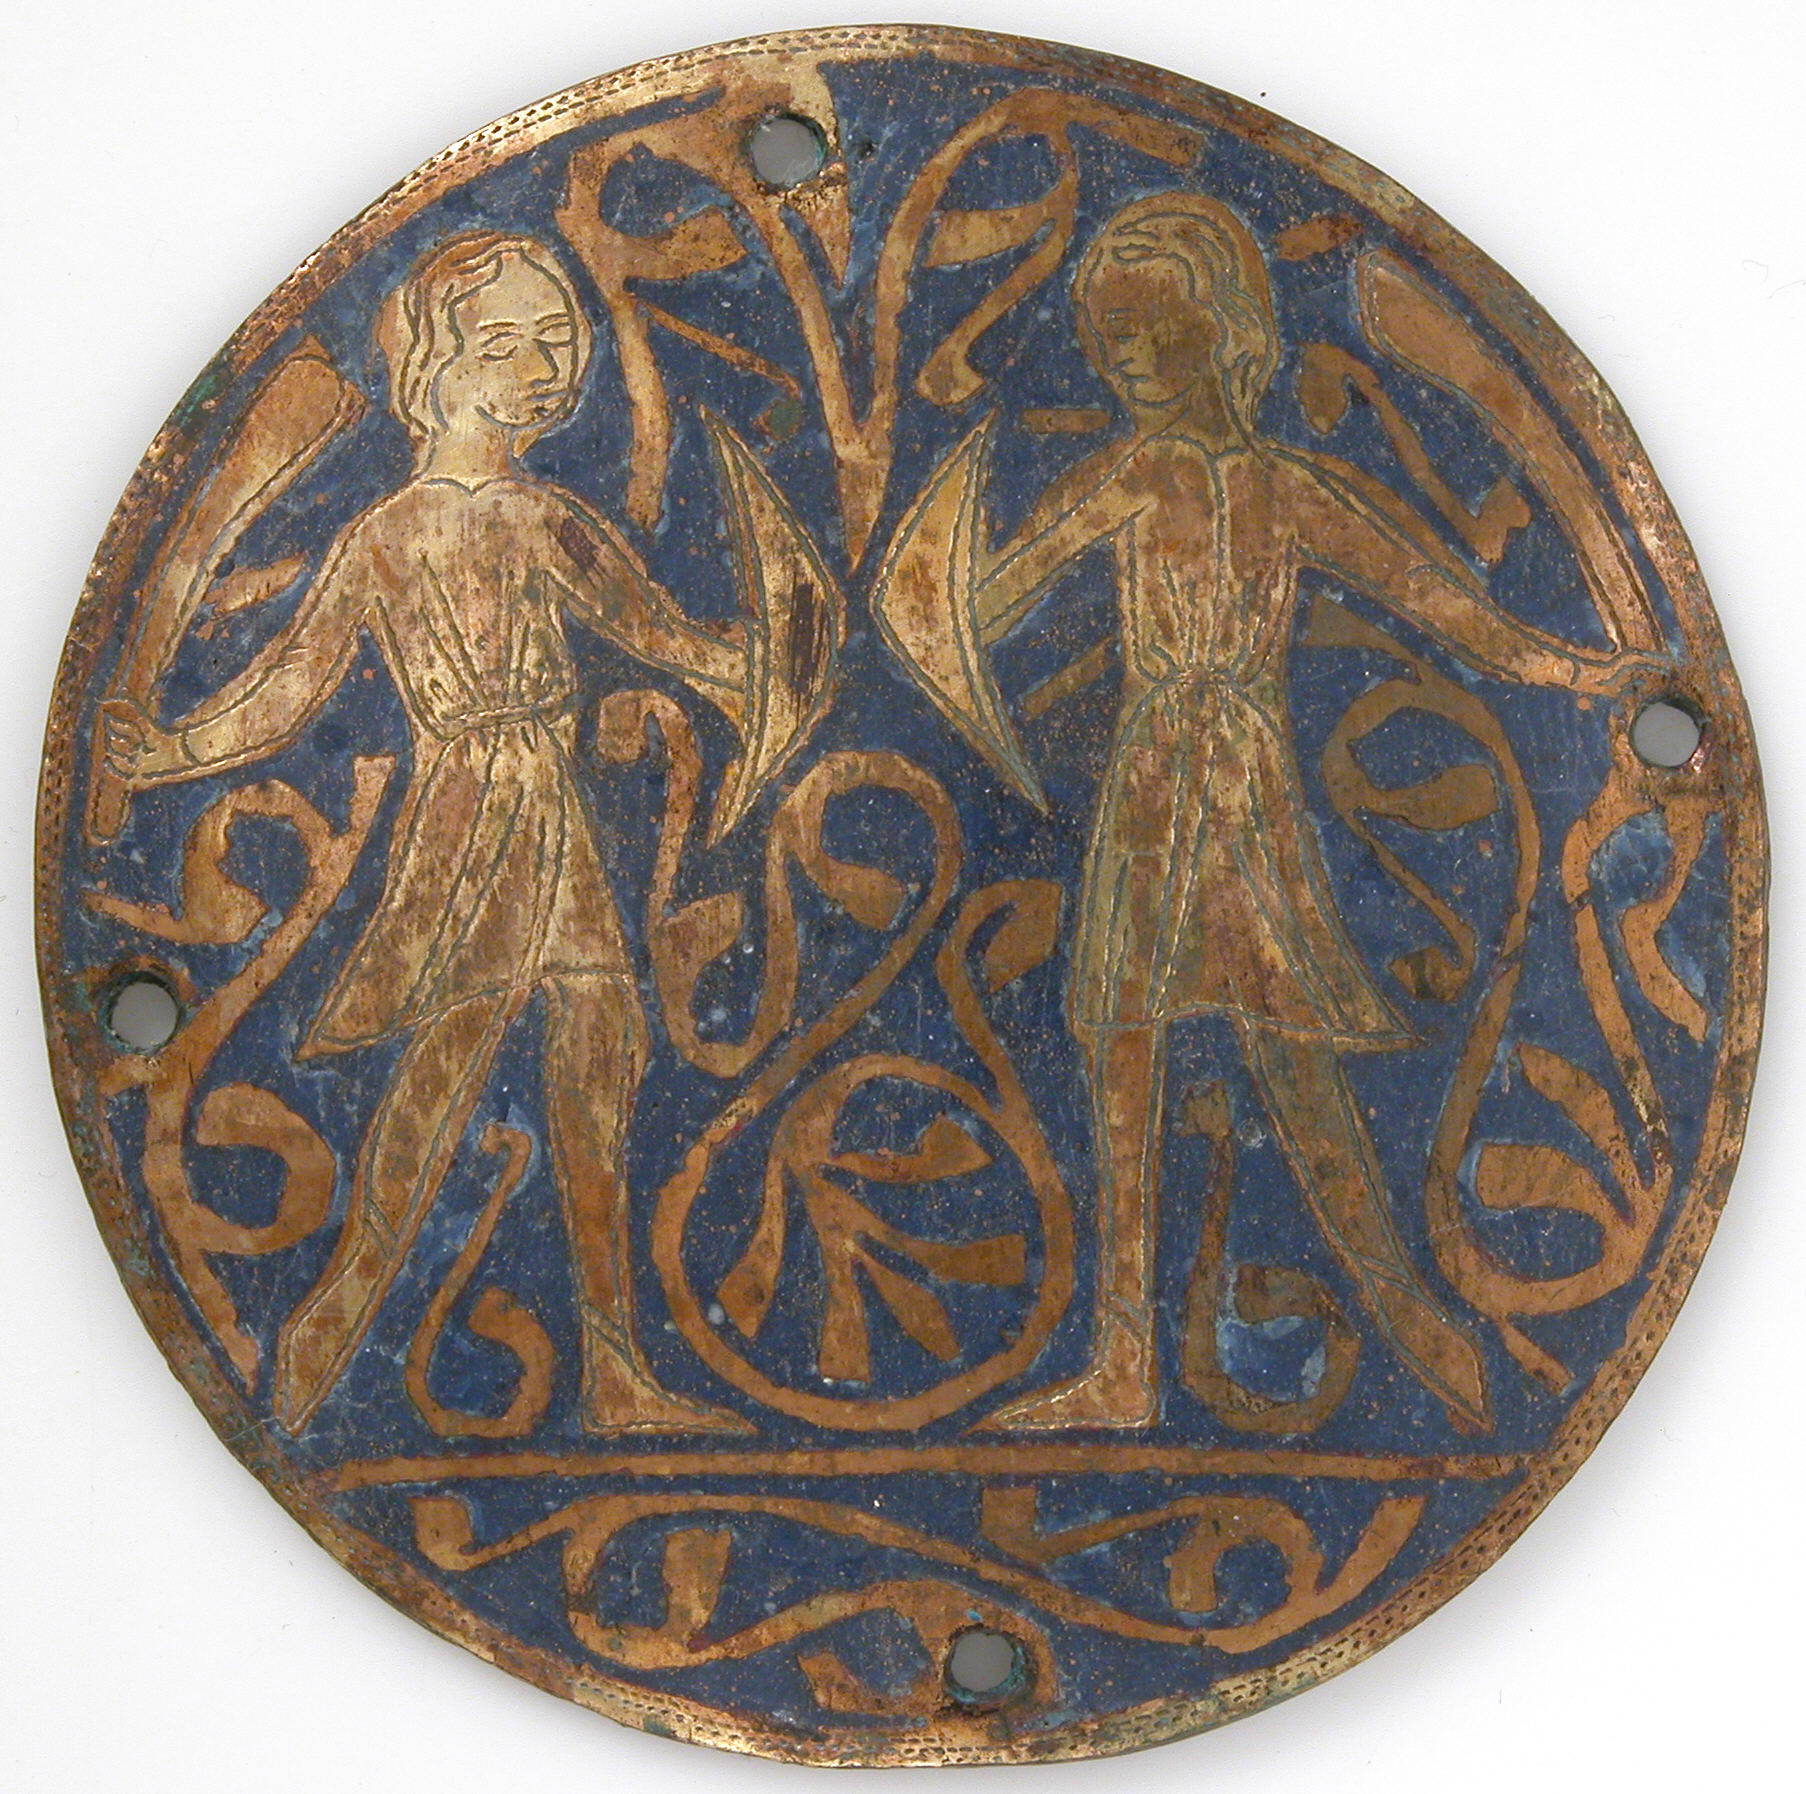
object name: medallion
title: Medallion with Two Young Warriors with Falchions and Bucklers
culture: french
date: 1240-1260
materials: copper, enamel, gilt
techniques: enamel, engraving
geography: france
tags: weapons,men